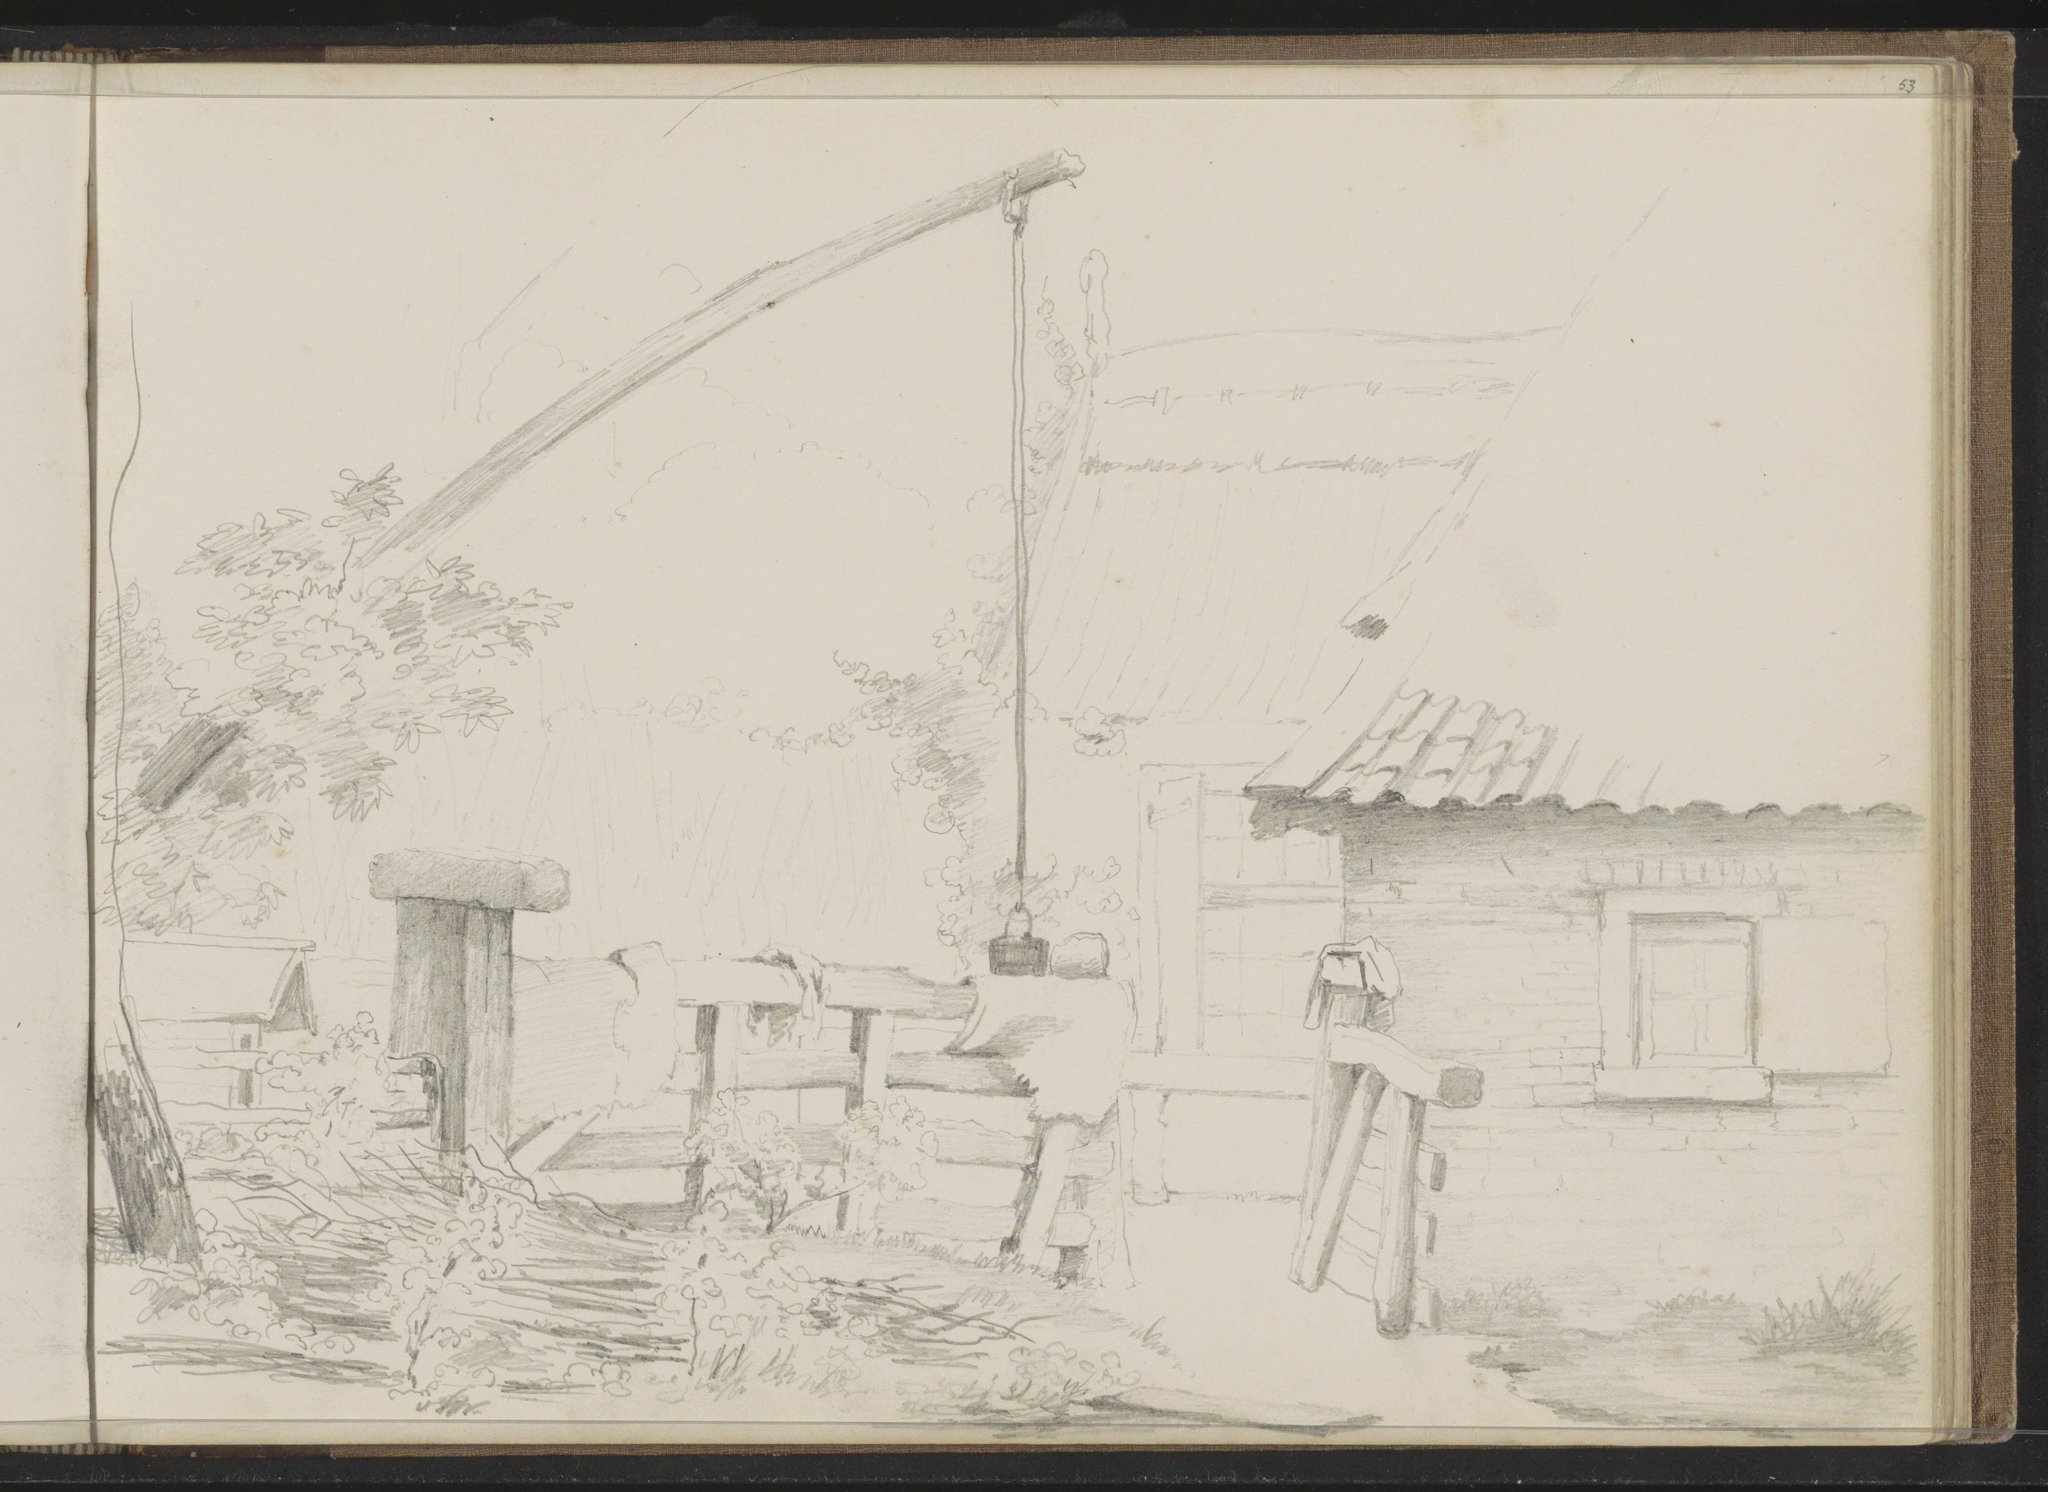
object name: sketchbook leaf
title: Waterput bij een boerderij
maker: hendrik valkenburg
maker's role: draughtsman, painter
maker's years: 1826-1896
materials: paper, pencil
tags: well, farm (building)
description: Blad 53 recto uit een schetsboek met 77 bladen.